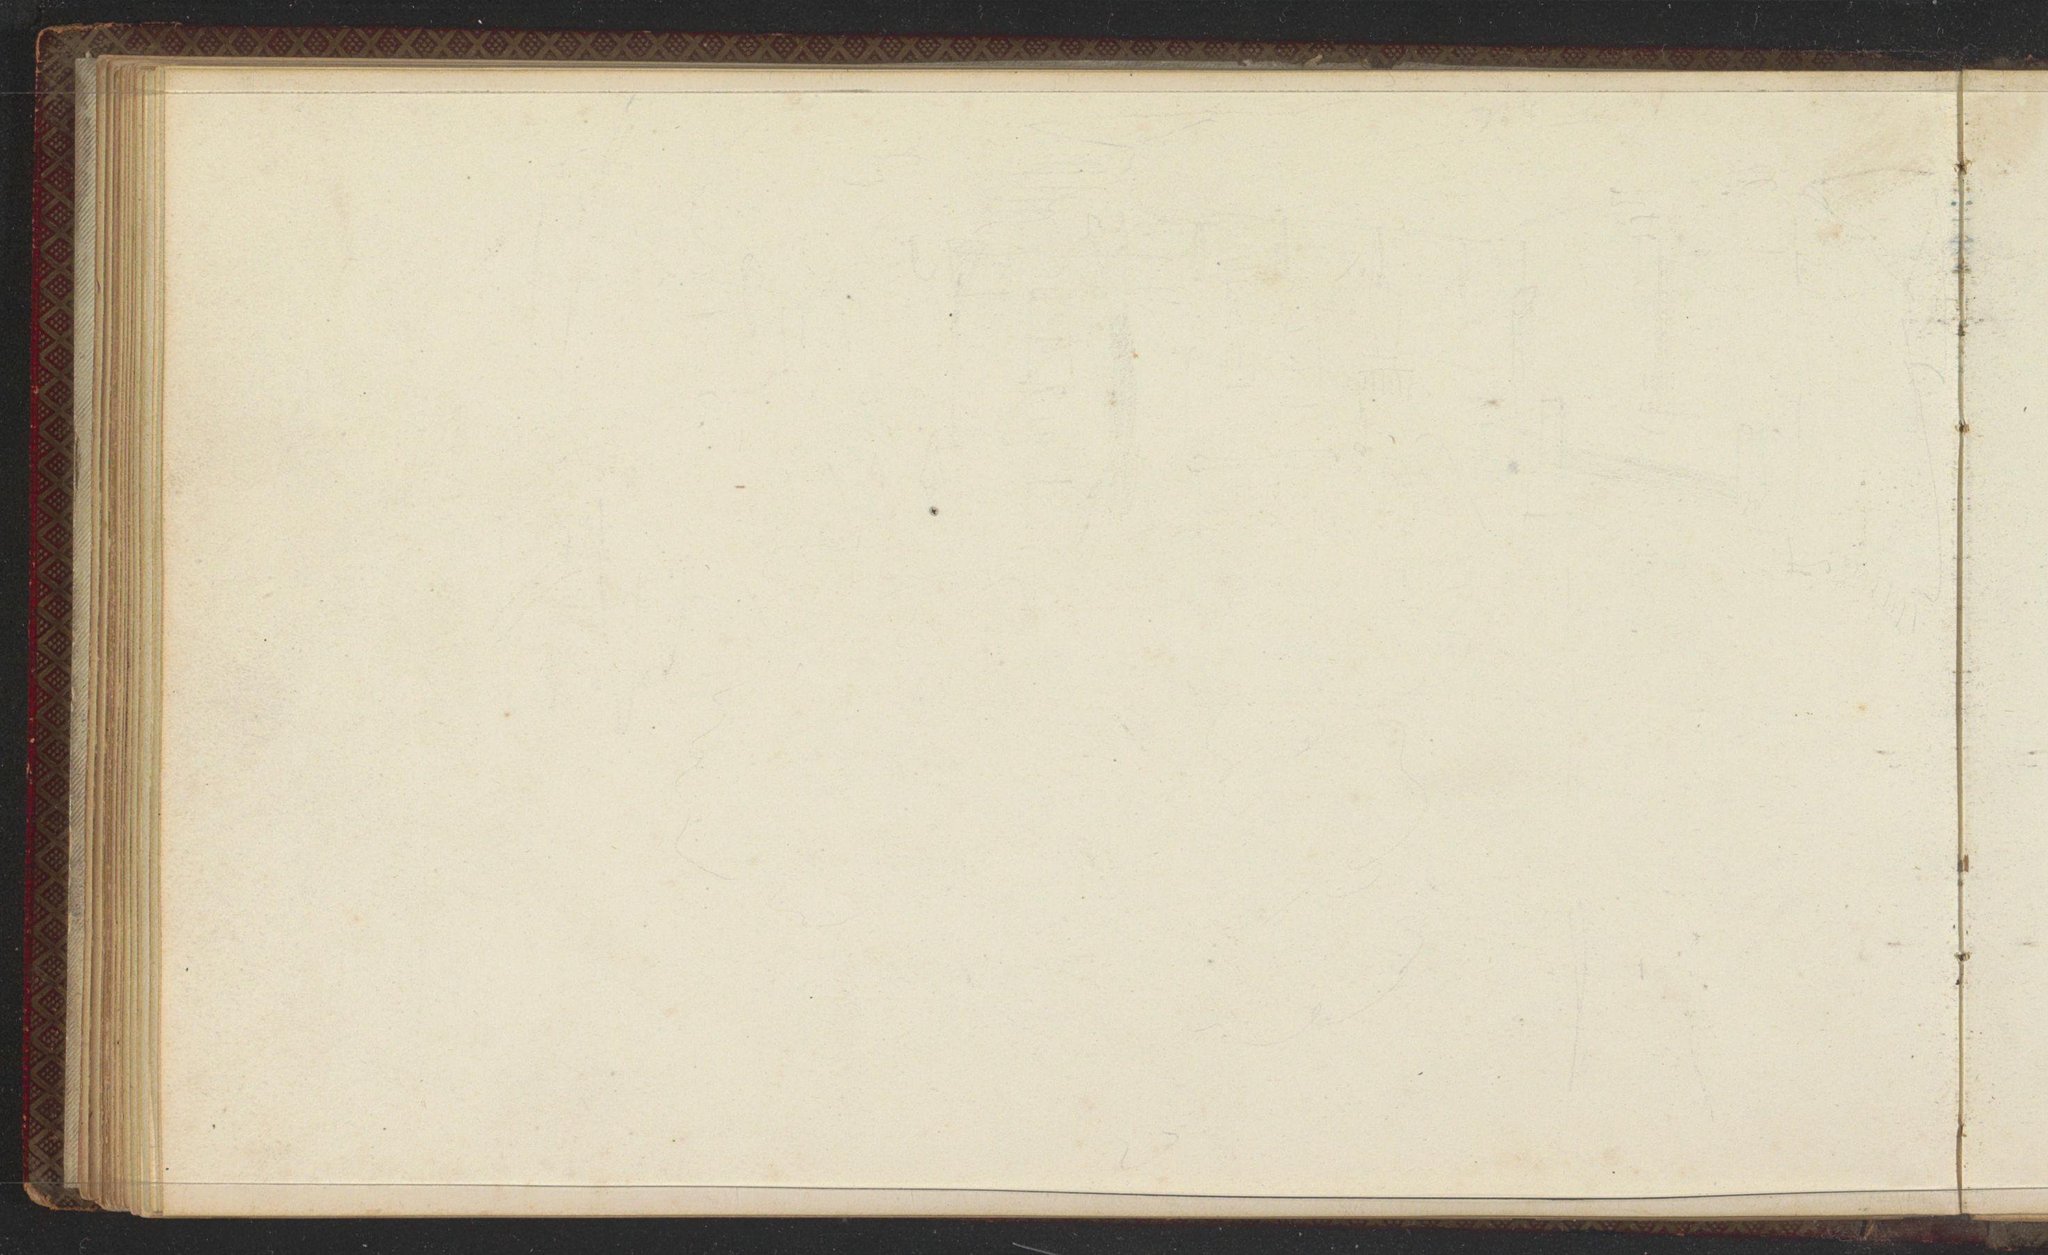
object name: sketchbook leaf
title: Studie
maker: adrianus eversen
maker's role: draughtsman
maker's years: 1818-1897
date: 1828-1897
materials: paper, pencil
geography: netherlands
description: Studie. Blad 39 verso uit een schetsboek met 52 bladen vervaardigd in de omgeving van Kampen, Hattem, Hoorn en Zwolle.